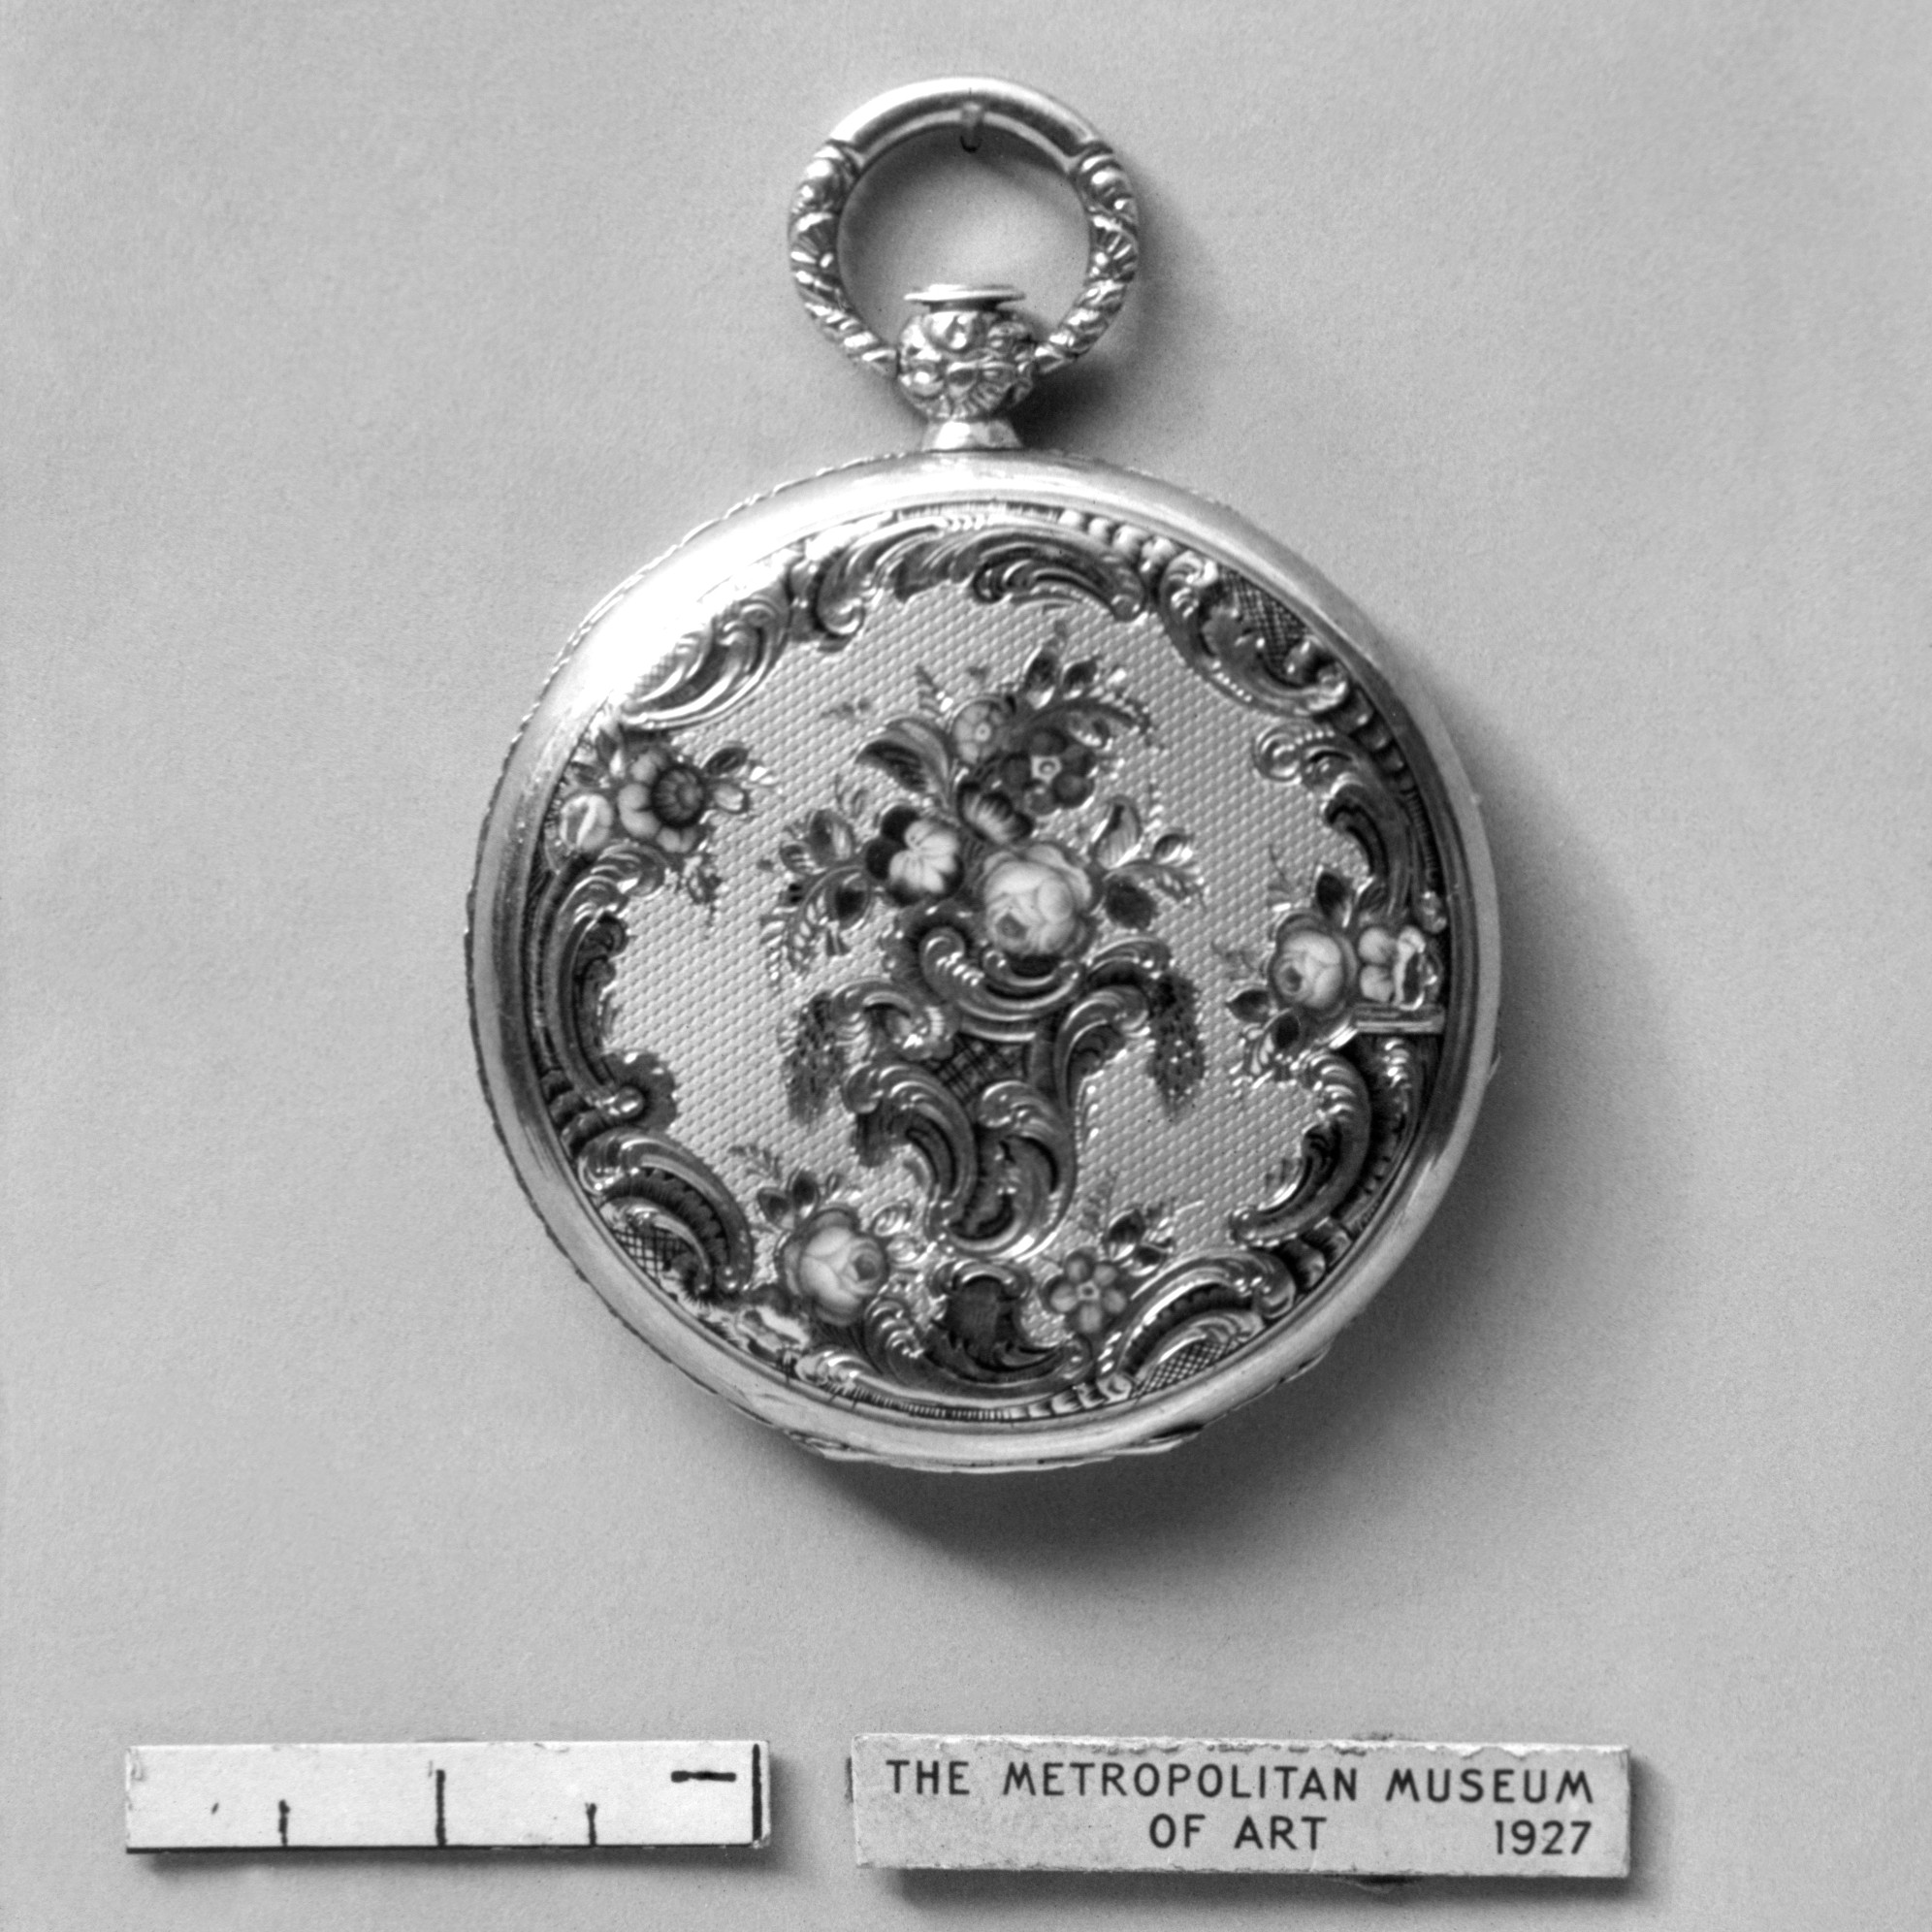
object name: watch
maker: charles oudin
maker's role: maker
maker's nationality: french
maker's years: 1768-1840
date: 1835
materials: enamel, gold, silver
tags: flowers,leaves